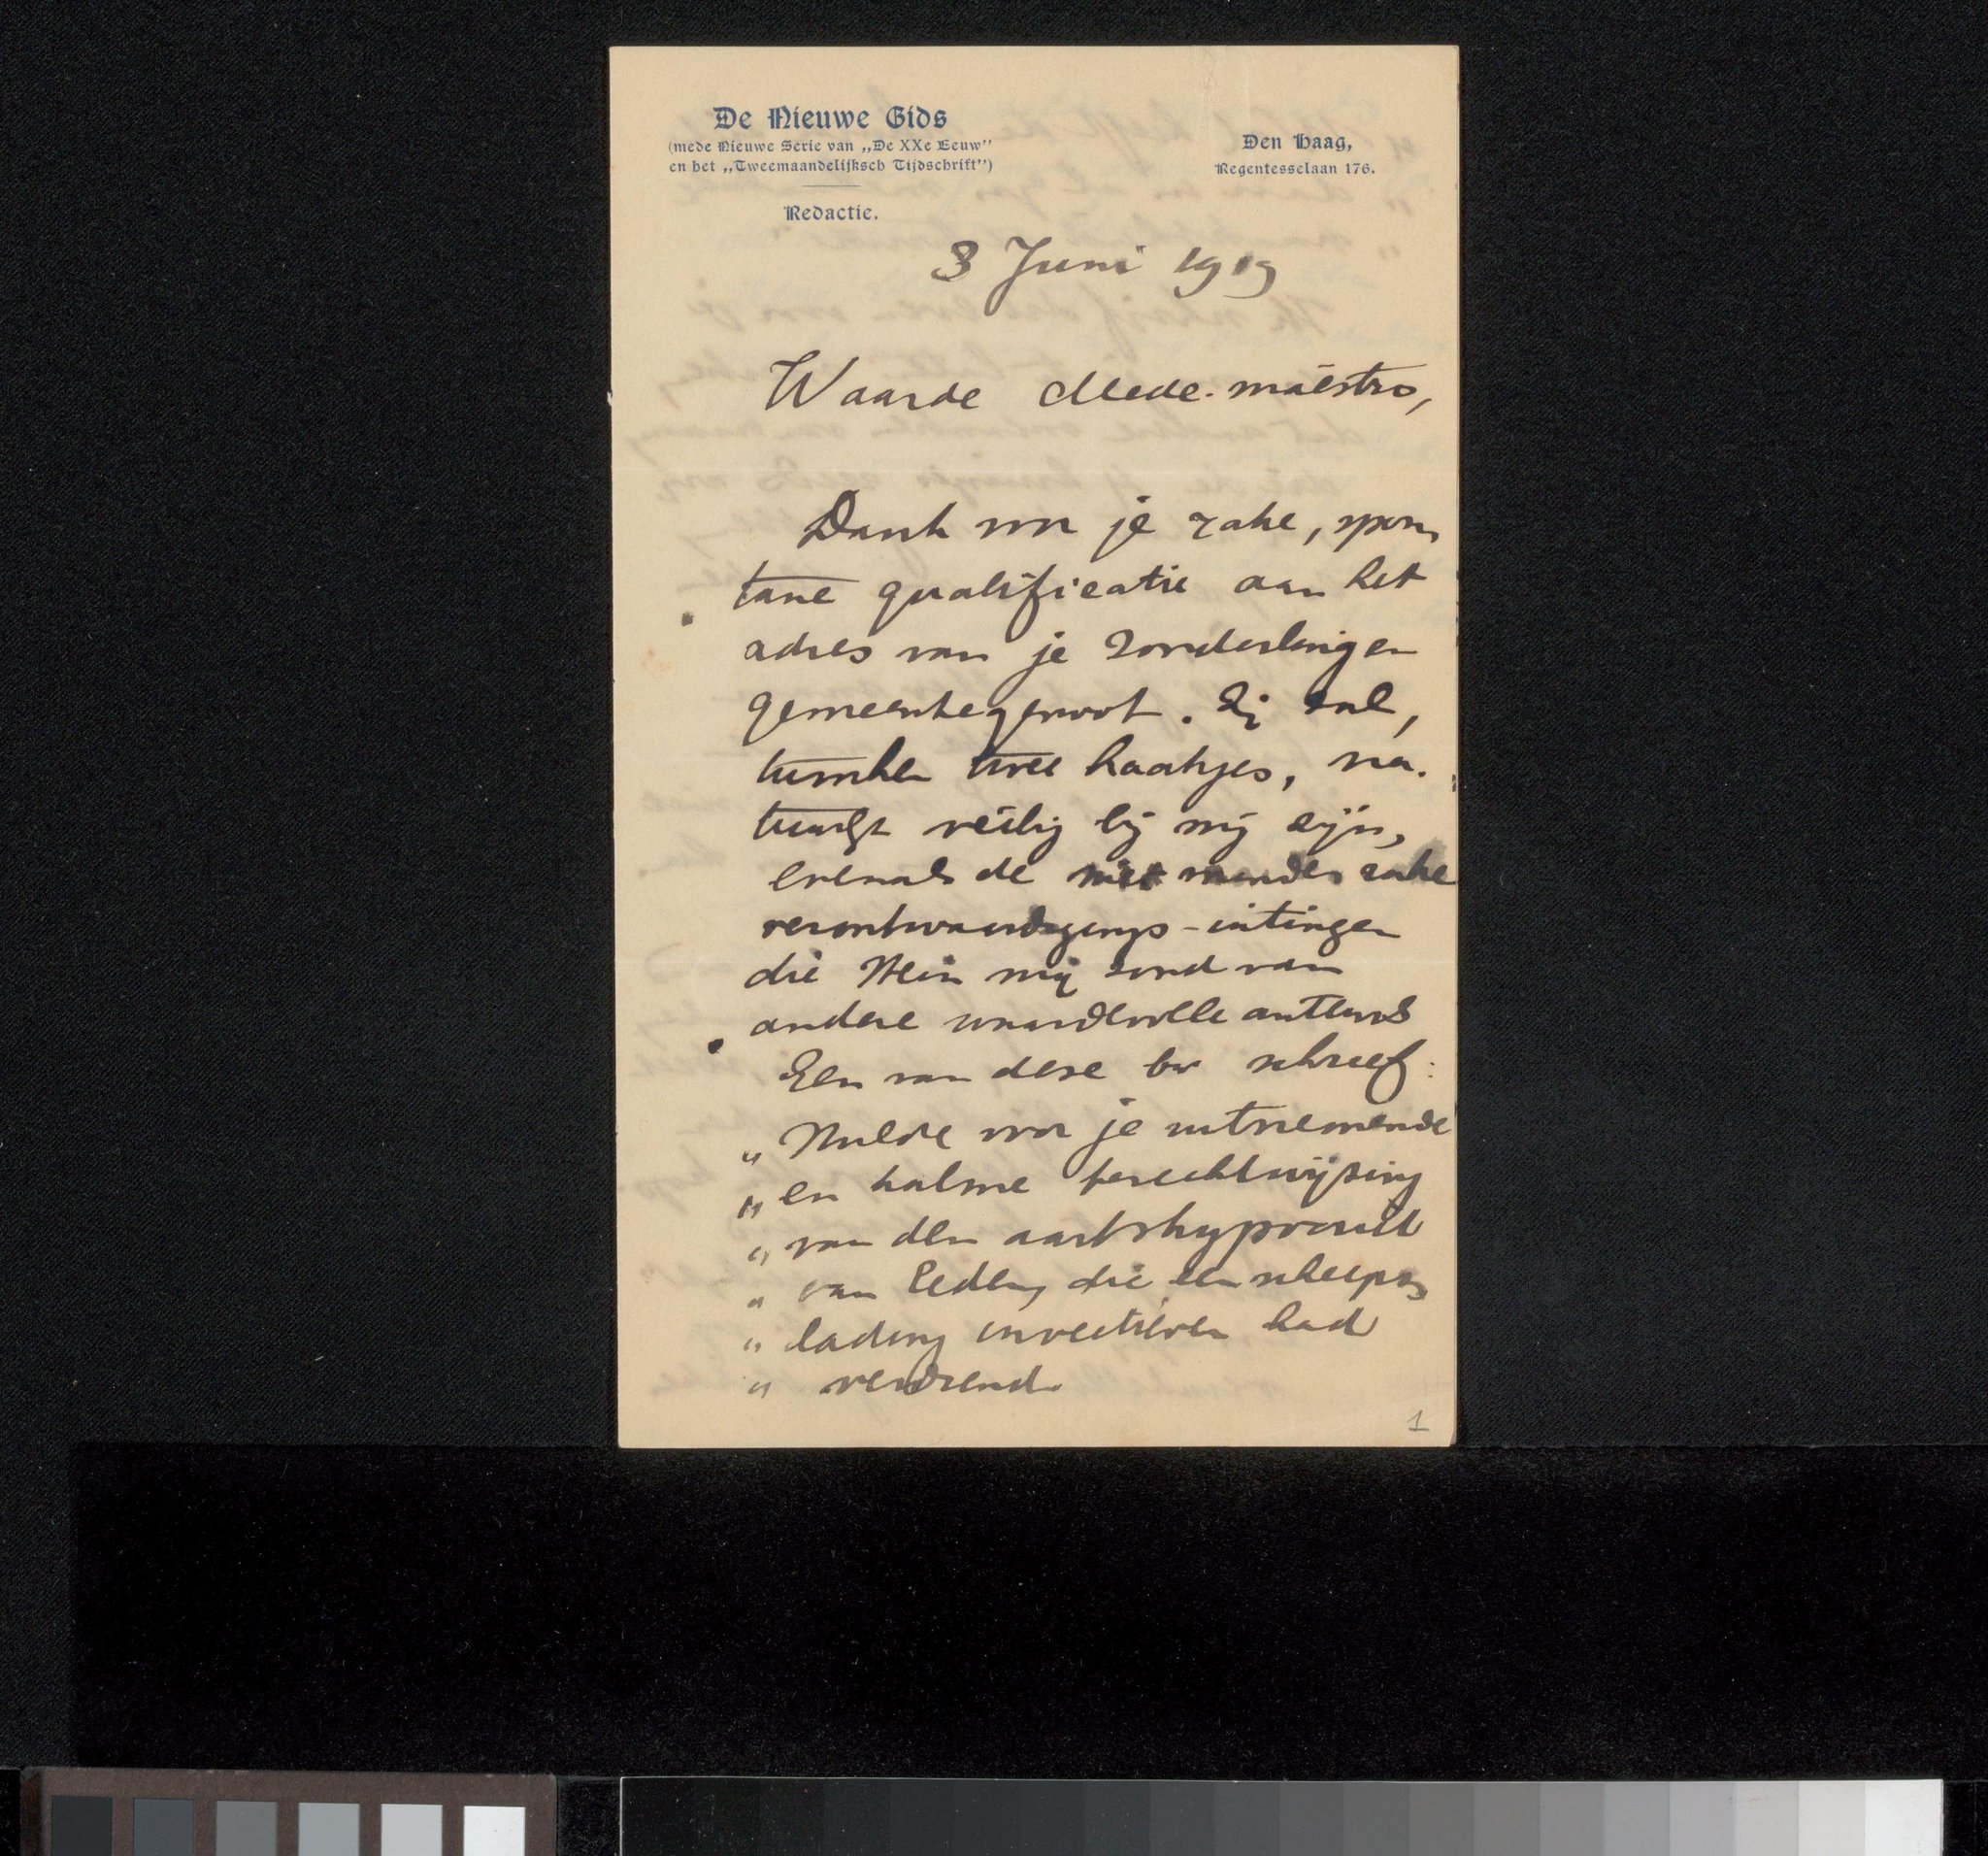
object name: letter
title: Brief aan Jan Veth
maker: willem kloos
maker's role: dichter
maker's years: 1859-1938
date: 1919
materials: ink, paper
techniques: pen, printing, writing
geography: the hague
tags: dordrecht, amsterdam, painter, draughtsman, designer, jan veth, the hague, emma (queen consort of the netherlands), haarlem, frederik van eeden, hein boeken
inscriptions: collector's mark: ‘RPK’